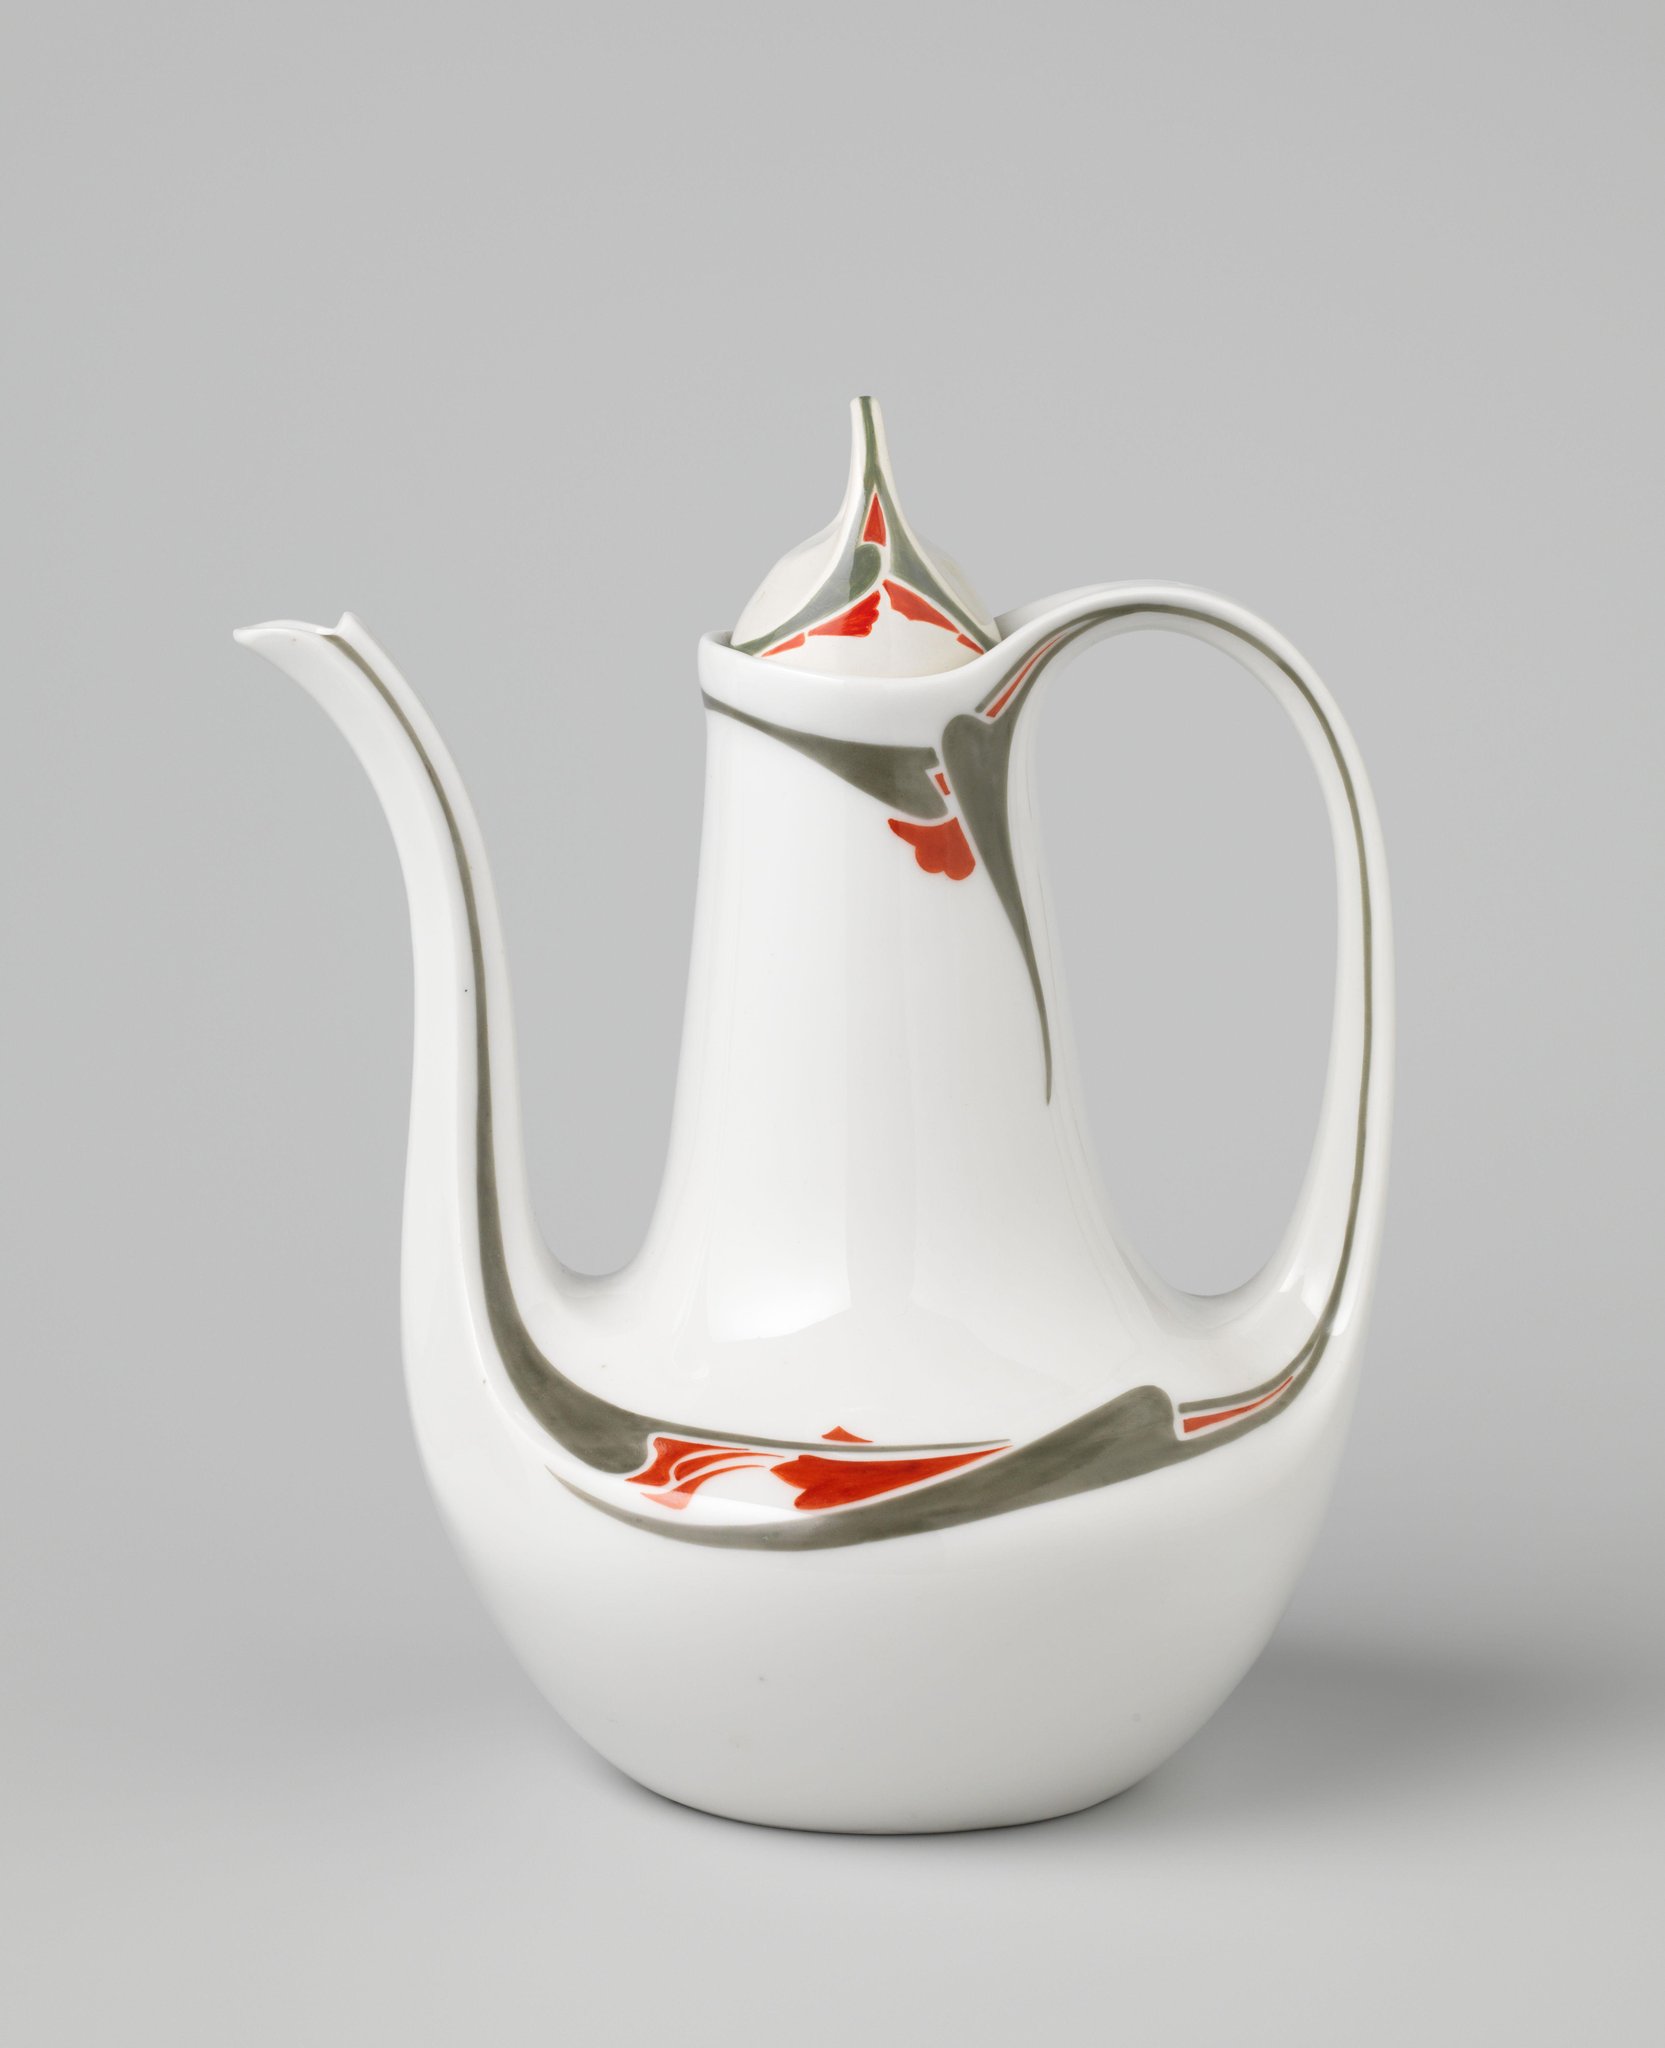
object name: coffee service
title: Cover of a coffeepot with stylized floral motifs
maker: maurice dufrêne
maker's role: designer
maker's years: 1876-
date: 1900-1905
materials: paint, plastic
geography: paris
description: Deksel van een koffiekan van kunststof met een opstaand handvat, beschilderd in groen en rood. Op de deksel, doorlopend op het handvat, gestileerde bloemtakken. De deksel is een kunststof vervanging voor het origineel. Naar ontwerp van Maurice Dufrêne, vervaardigd voor La Maison Moderne, mogelijk door Le Parthénon, Parijs.